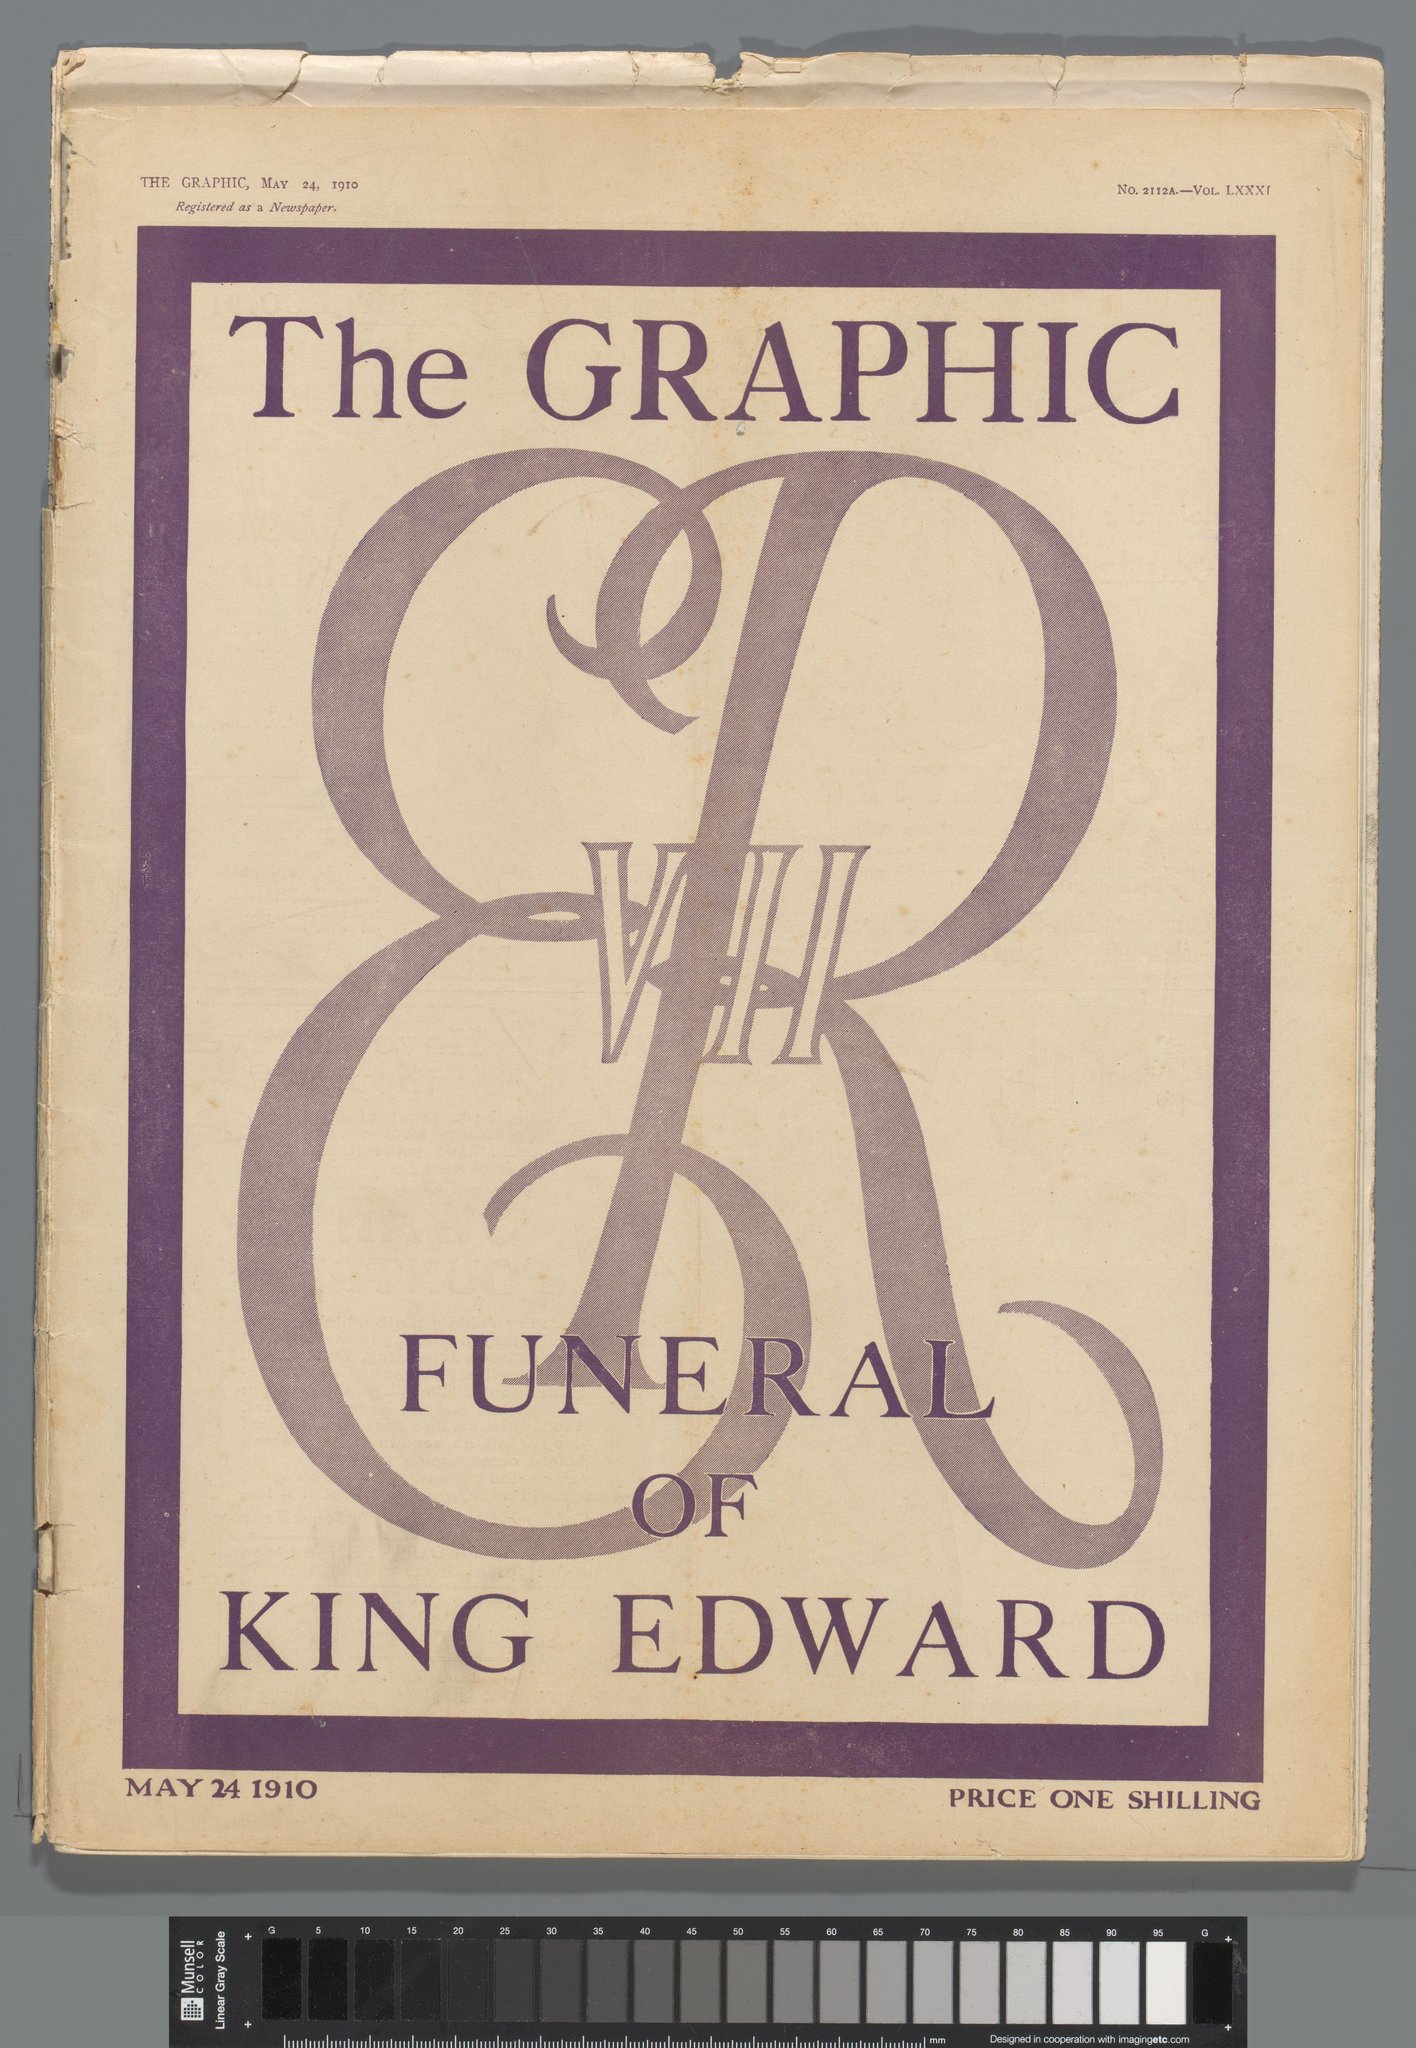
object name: magazine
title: Exemplaar van het tijdschrift 'The Graphic' van 24 mei 1910 over de begrafenis van koning Eduard VII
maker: george robert parker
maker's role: publisher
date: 1910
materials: paper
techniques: printed materials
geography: london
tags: public festivities at other royal events, not meant or mentioned above, funerary ceremonial, london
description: Exemplaar van het tijdschrift 'The Graphic', no. 2112A van 24 mei 1910 over de begrafenis van de Britse koning Eduard VII op 17 mei 1910. Los achterin een opgevouwen voorstelling van de begrafenisstoet.